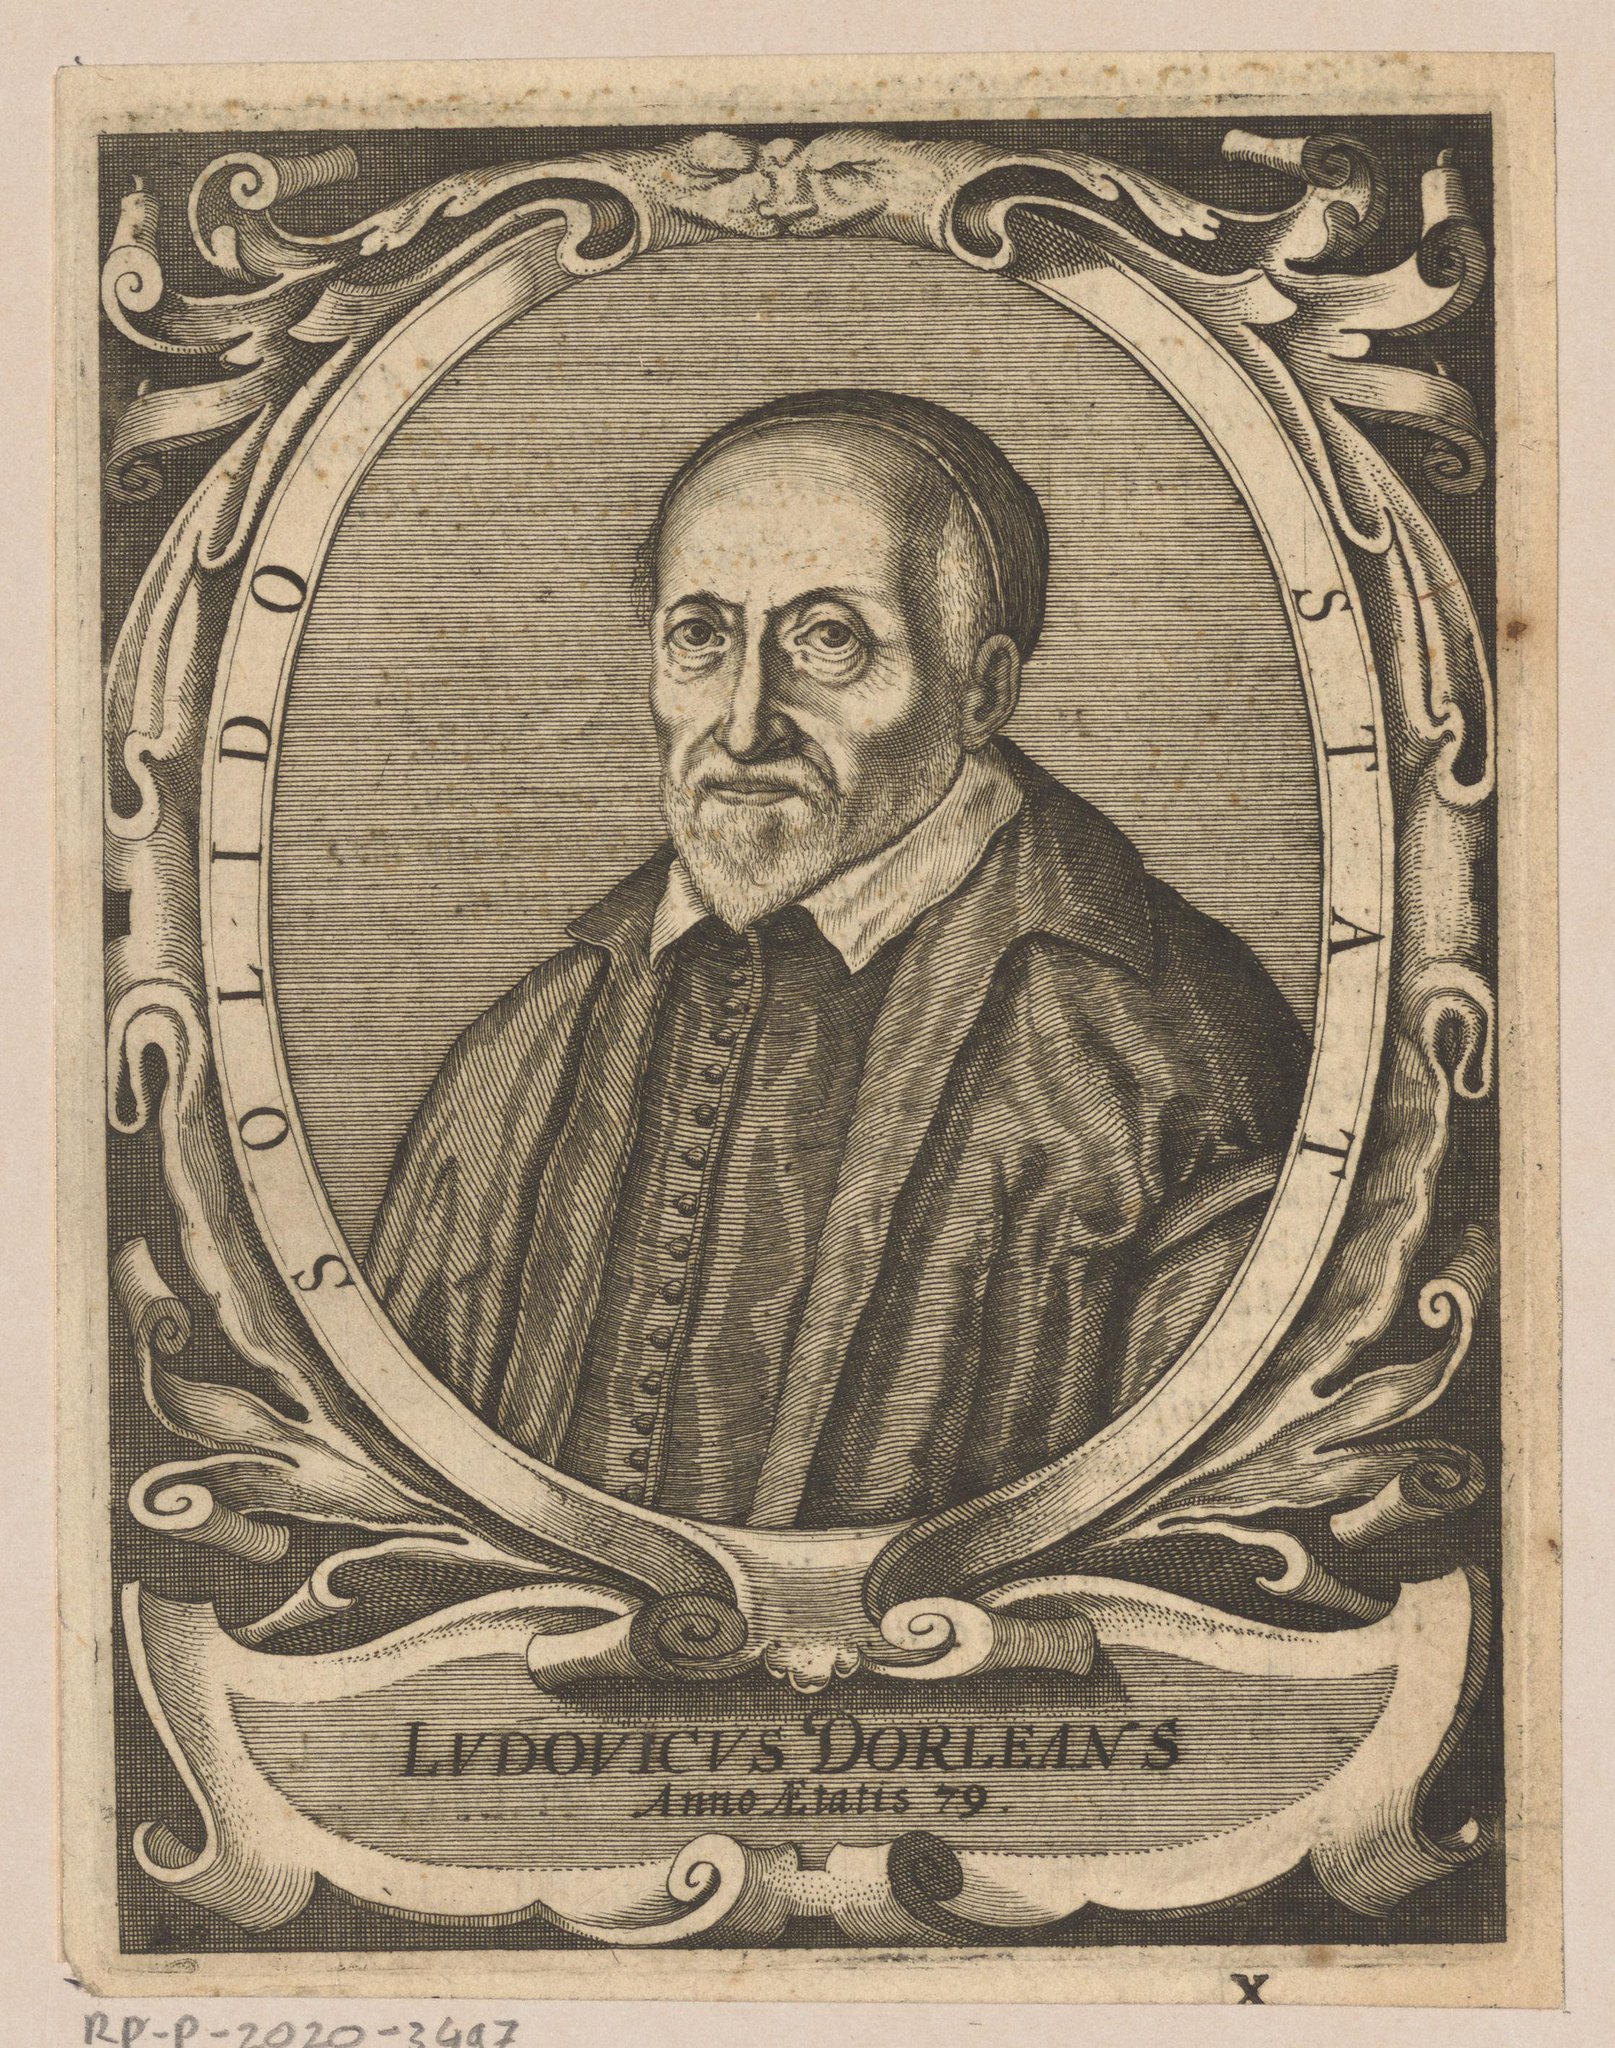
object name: book illustration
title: Portret van Louis Dorléans op 79-jarige leeftijd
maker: Anonymous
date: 1650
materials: paper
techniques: engraving, etching, letterpress printing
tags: paris, historical persons, lawyer, attorney at law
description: Later staat van prent gebruikt in: Bibliotheca chalcographica. Frankfurt am Main: Johannes Ammon, 1650.